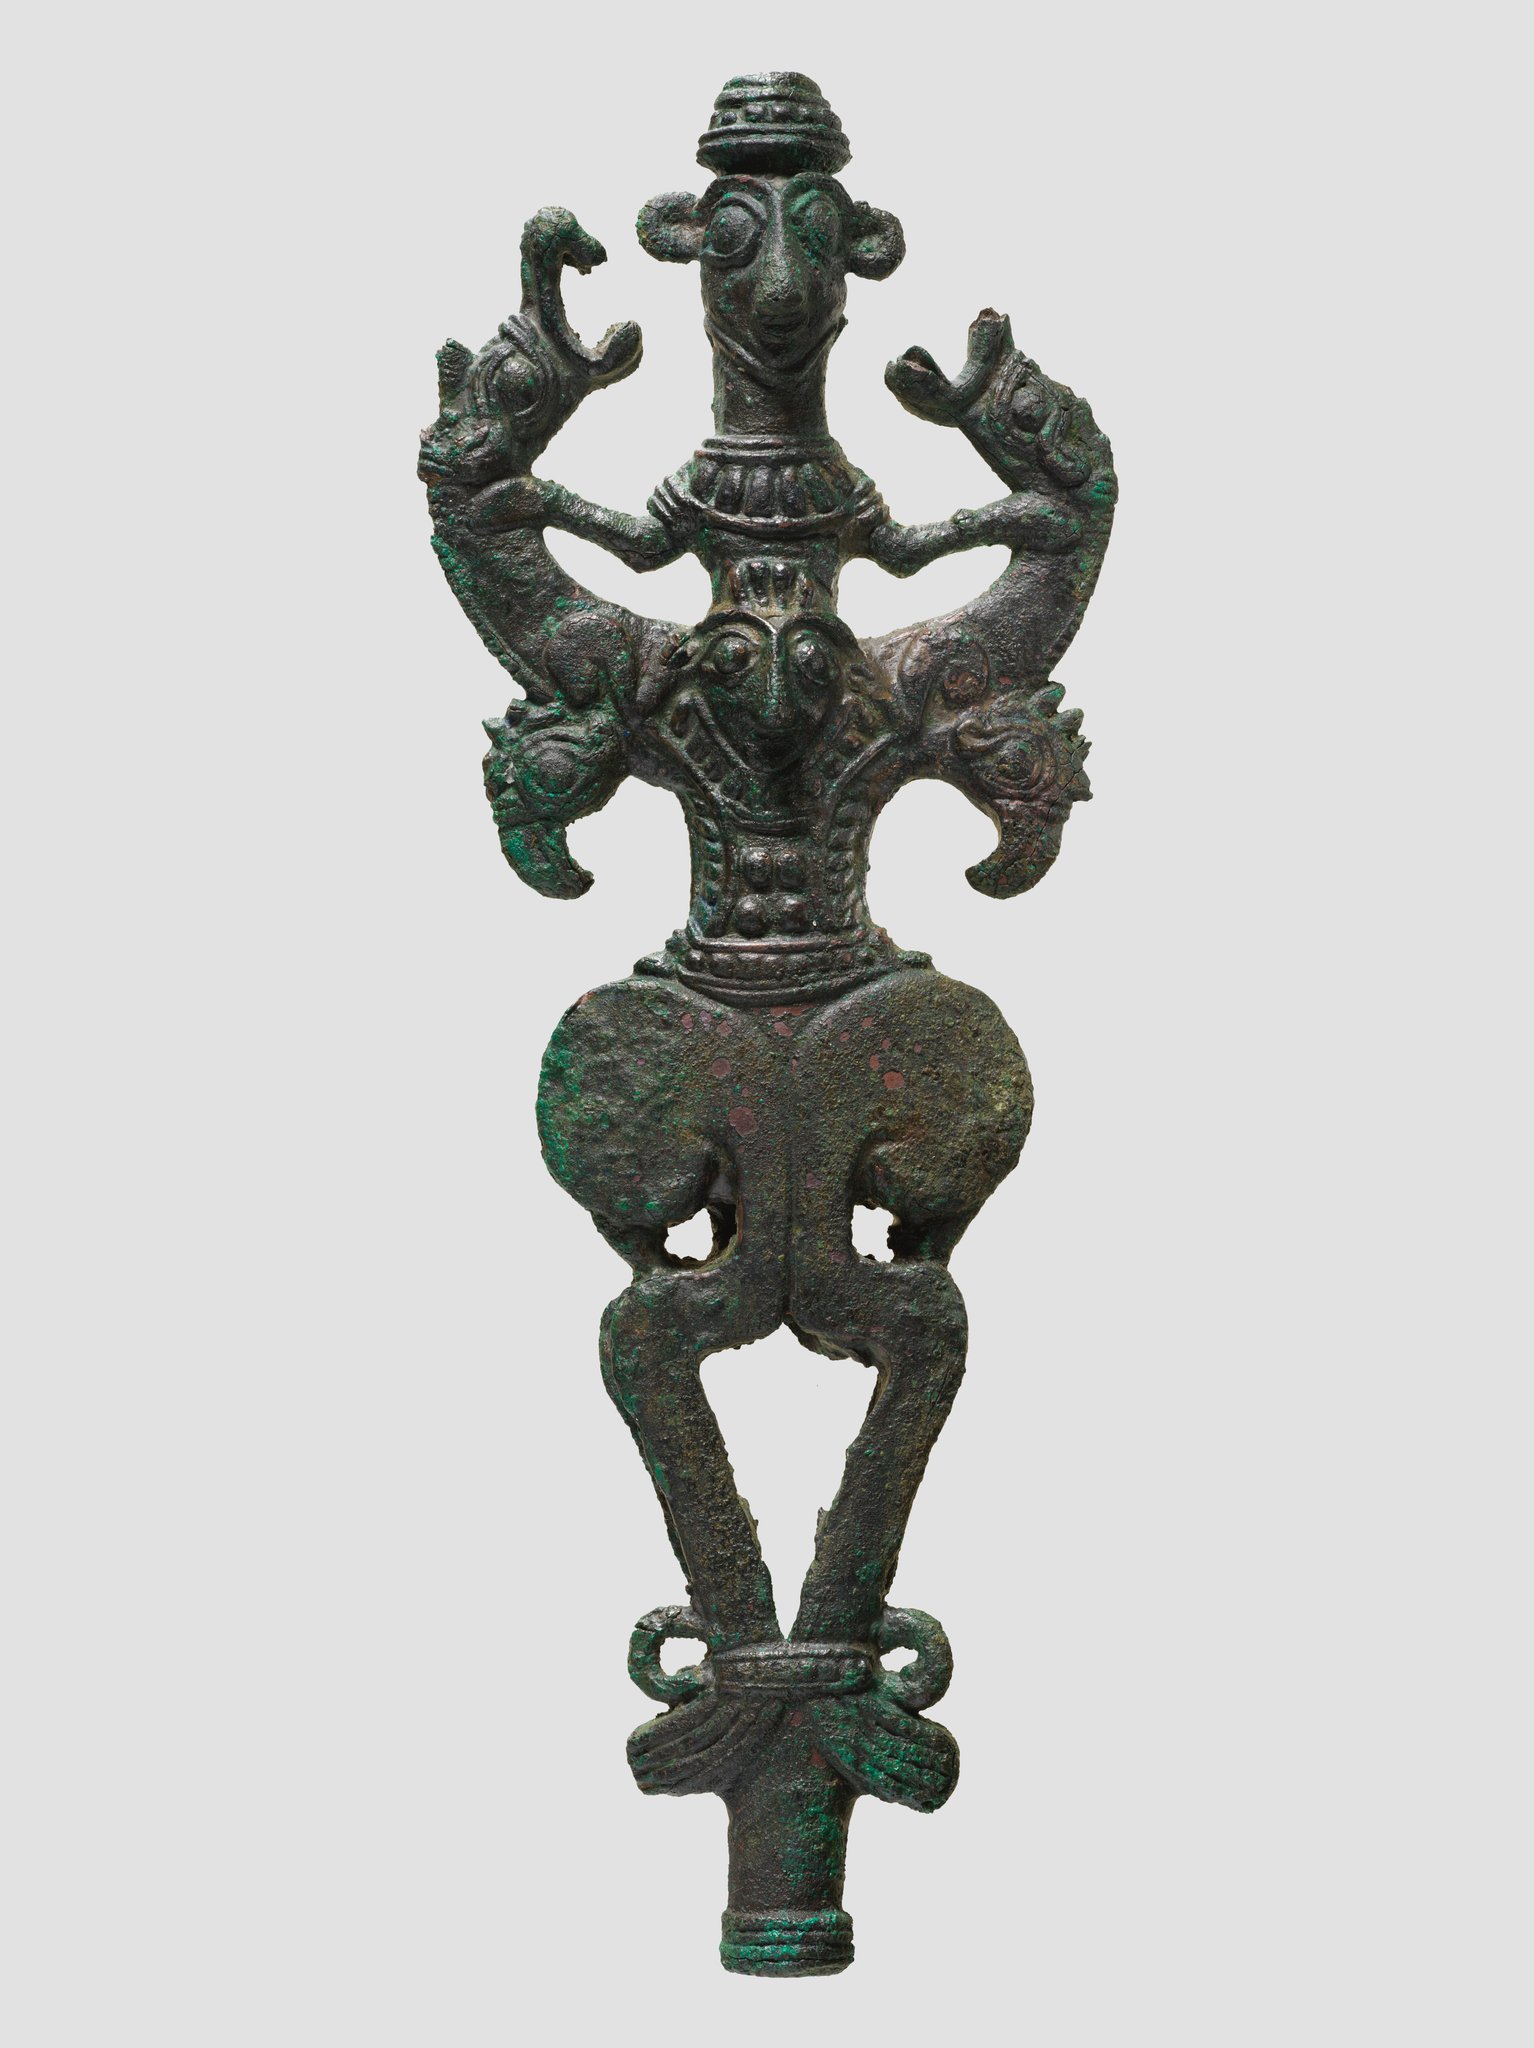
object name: standard top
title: Top for standard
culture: iranian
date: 800-701 BCE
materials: bronze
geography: iran, probably from luristan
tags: men,demons